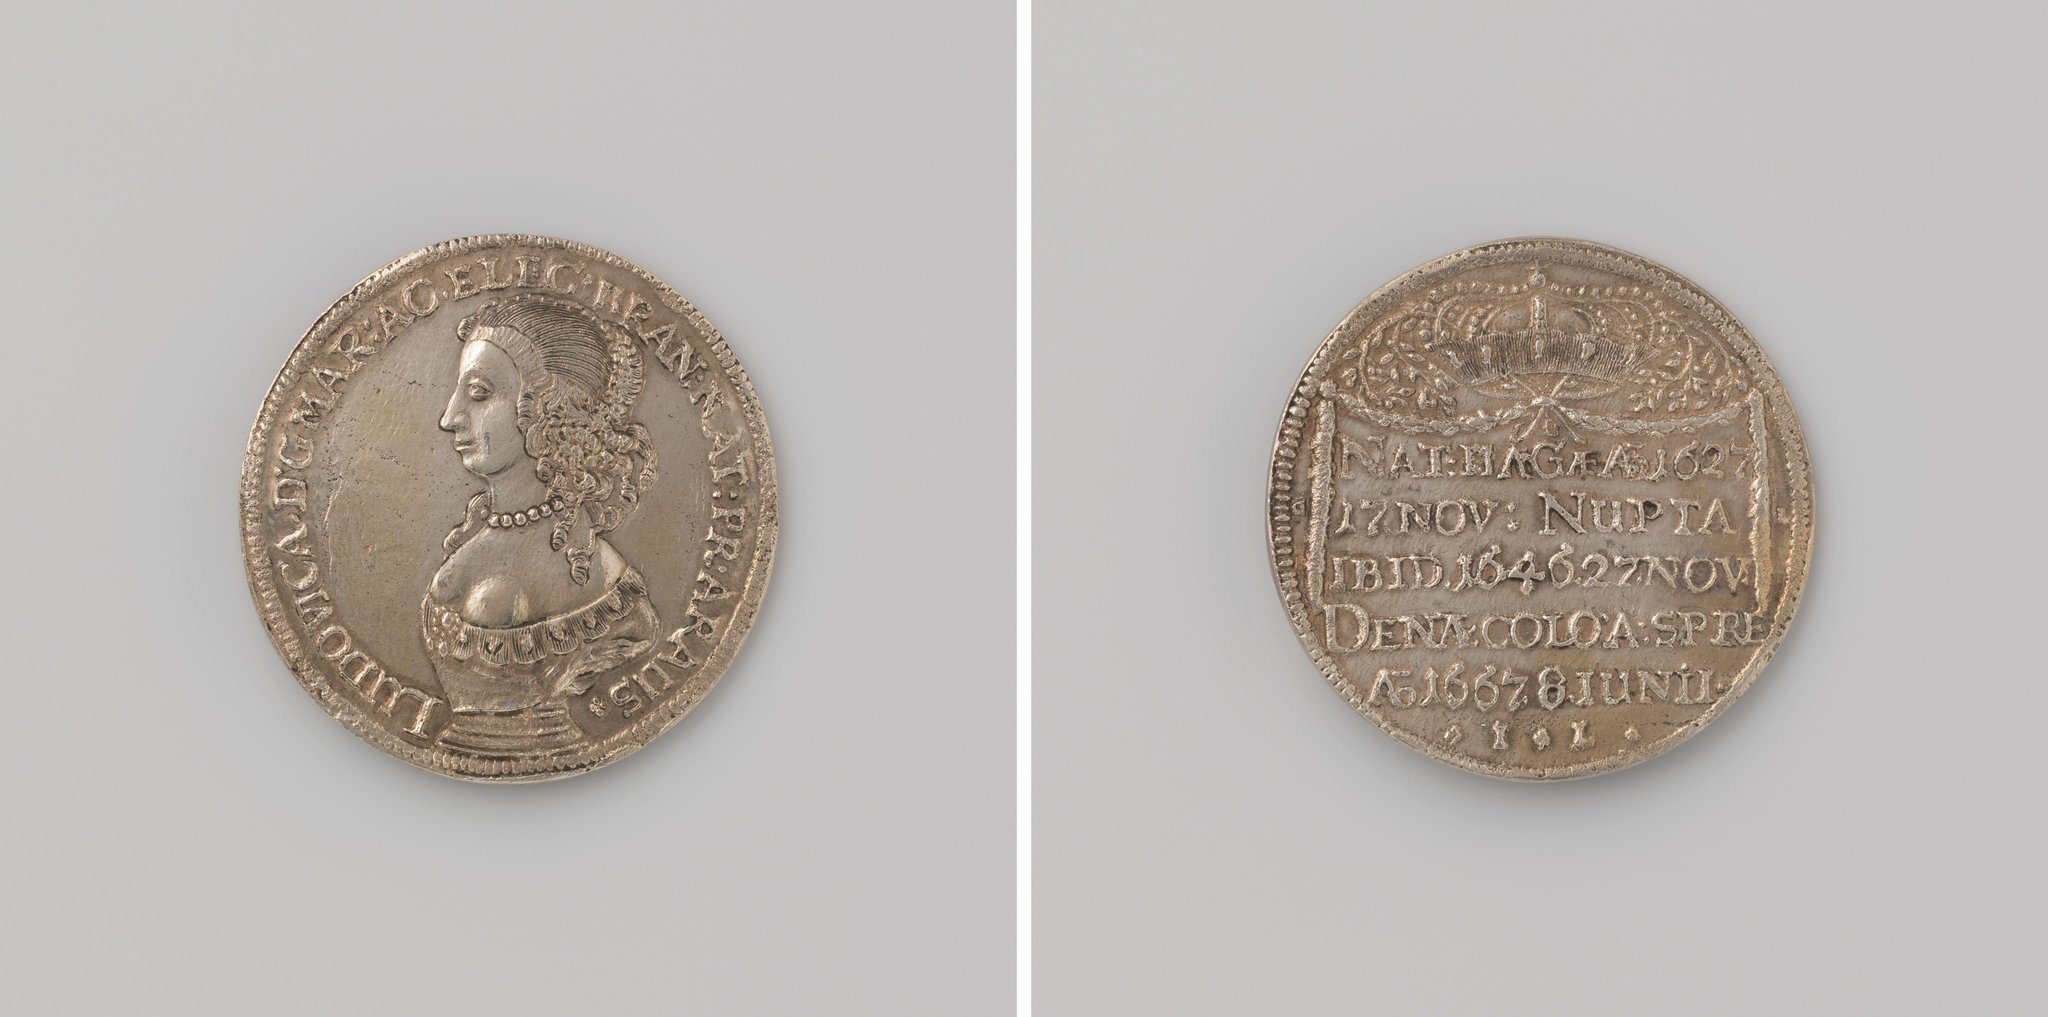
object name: history medal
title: Dood van prinses Louise Henriette van Oranje, gemalin van Frederik Willem, keurvorst van Brandenburg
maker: johann liebmann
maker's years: 1646-1682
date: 1667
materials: silver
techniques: striking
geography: berlin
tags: the hague, berlin, louise henriëtte (prinses van oranje)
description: Zilveren penning. Voorzijde: borststuk vrouw binnen omschrift. Keerzijde: opschrift onder keurvorstelijke kroon